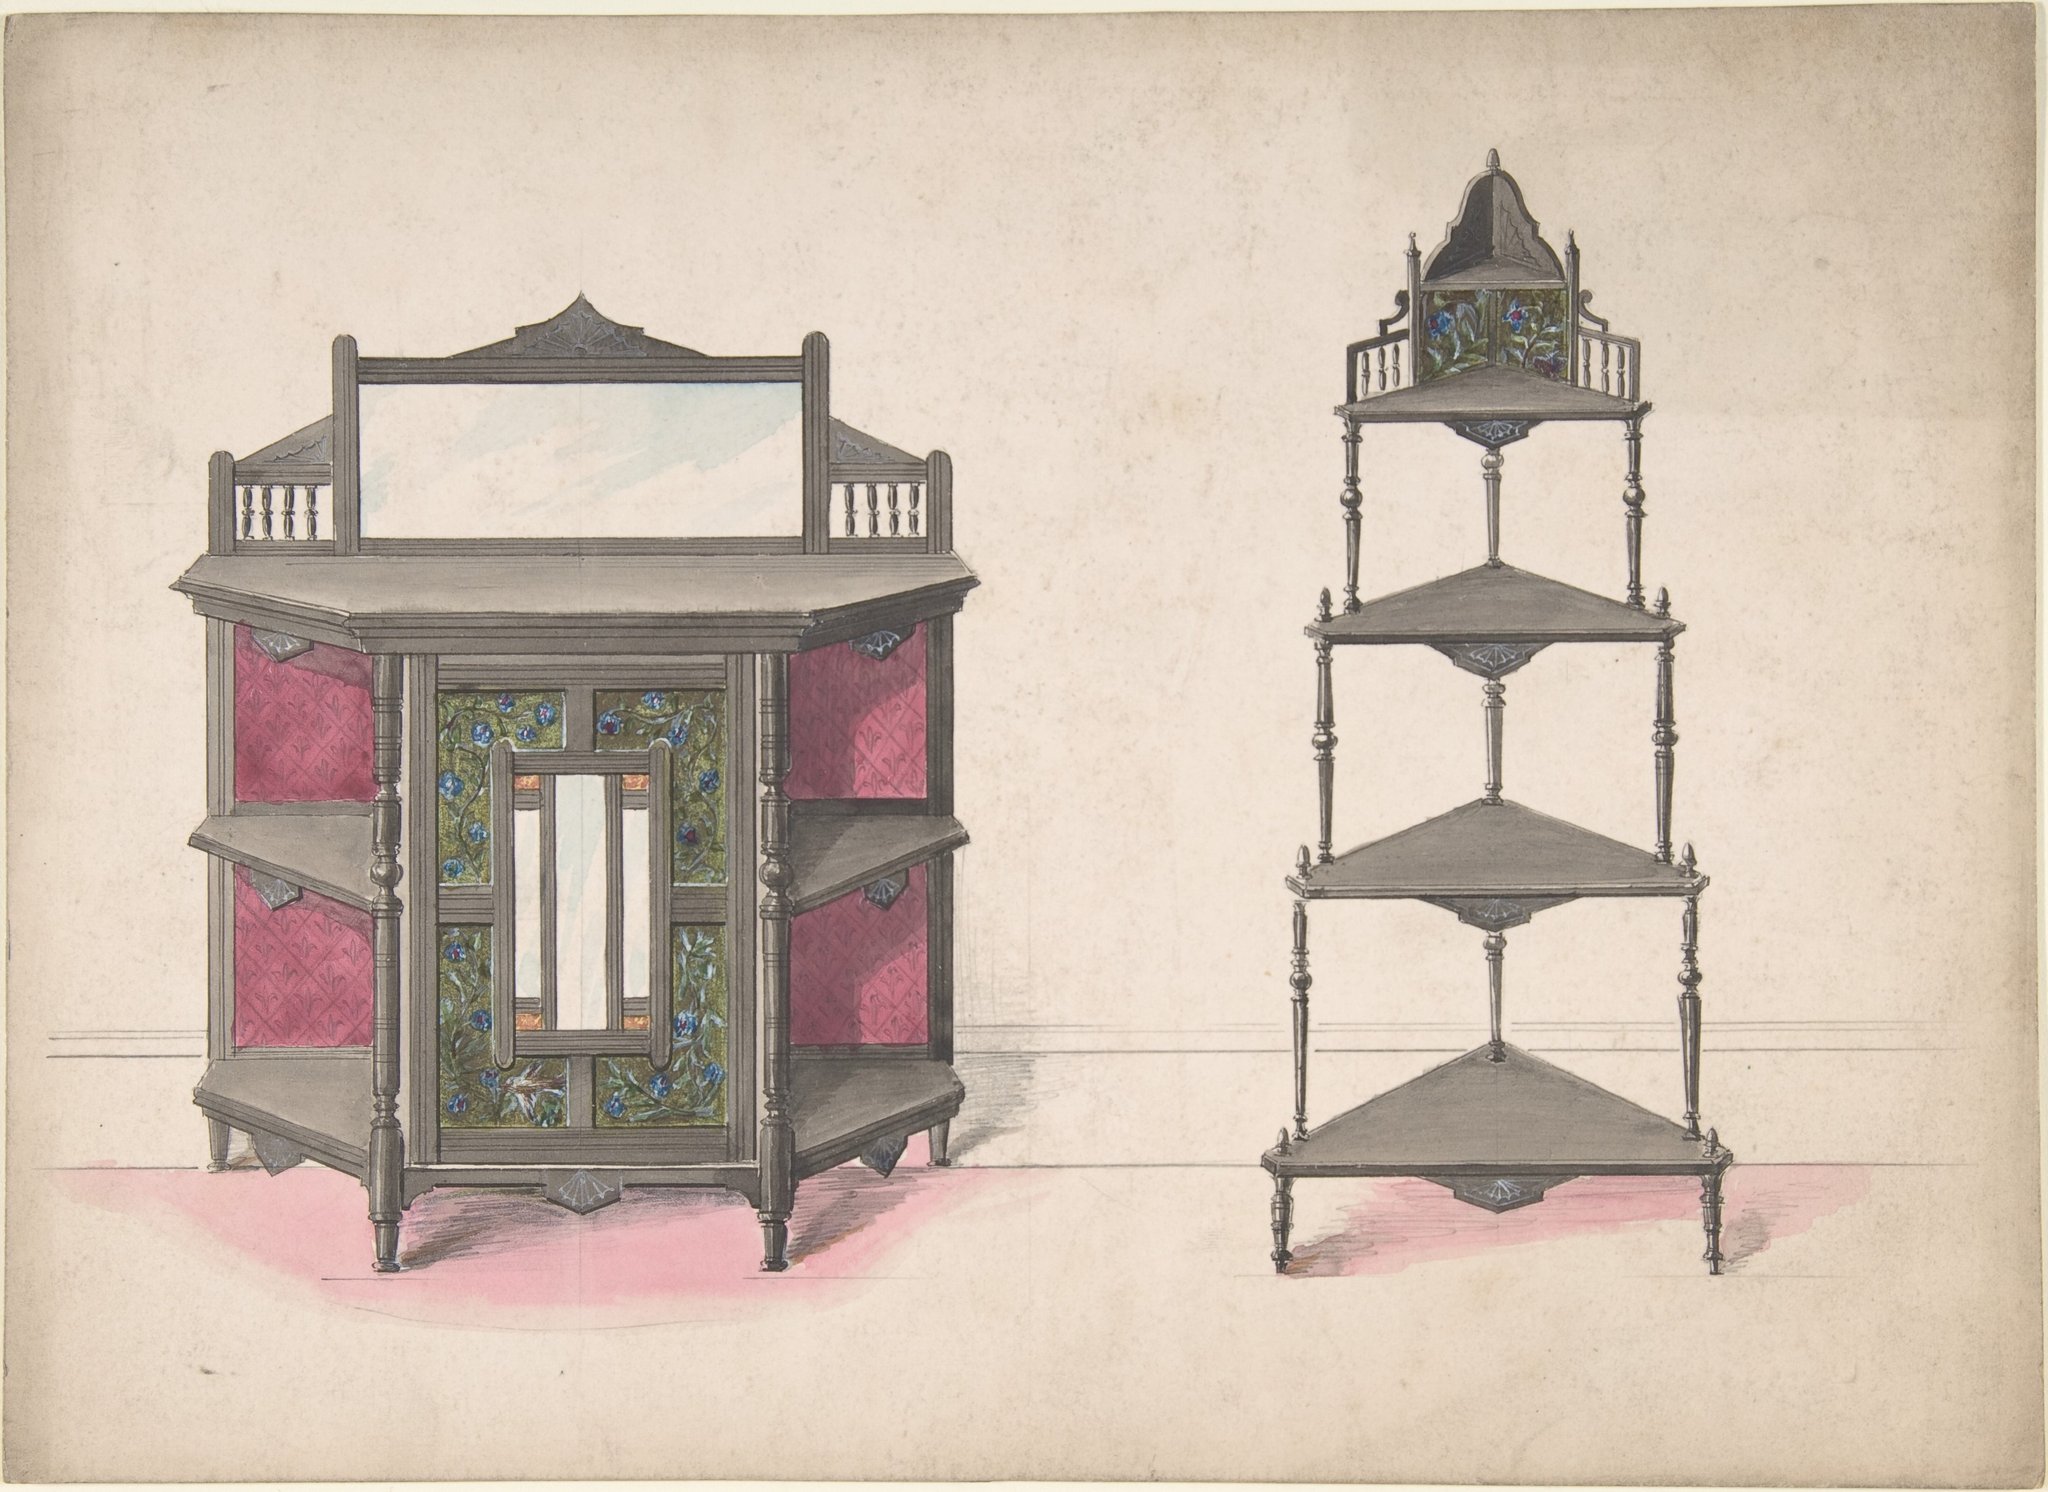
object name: drawing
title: Design for a Mirrored Cabinet and a Set of Corner Shelves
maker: anonymous, british, 19th century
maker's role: artist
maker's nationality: british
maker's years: 1800-1900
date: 1801-1900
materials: gouache, ink, watercolor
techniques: pen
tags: furniture,cabinets,mirrors